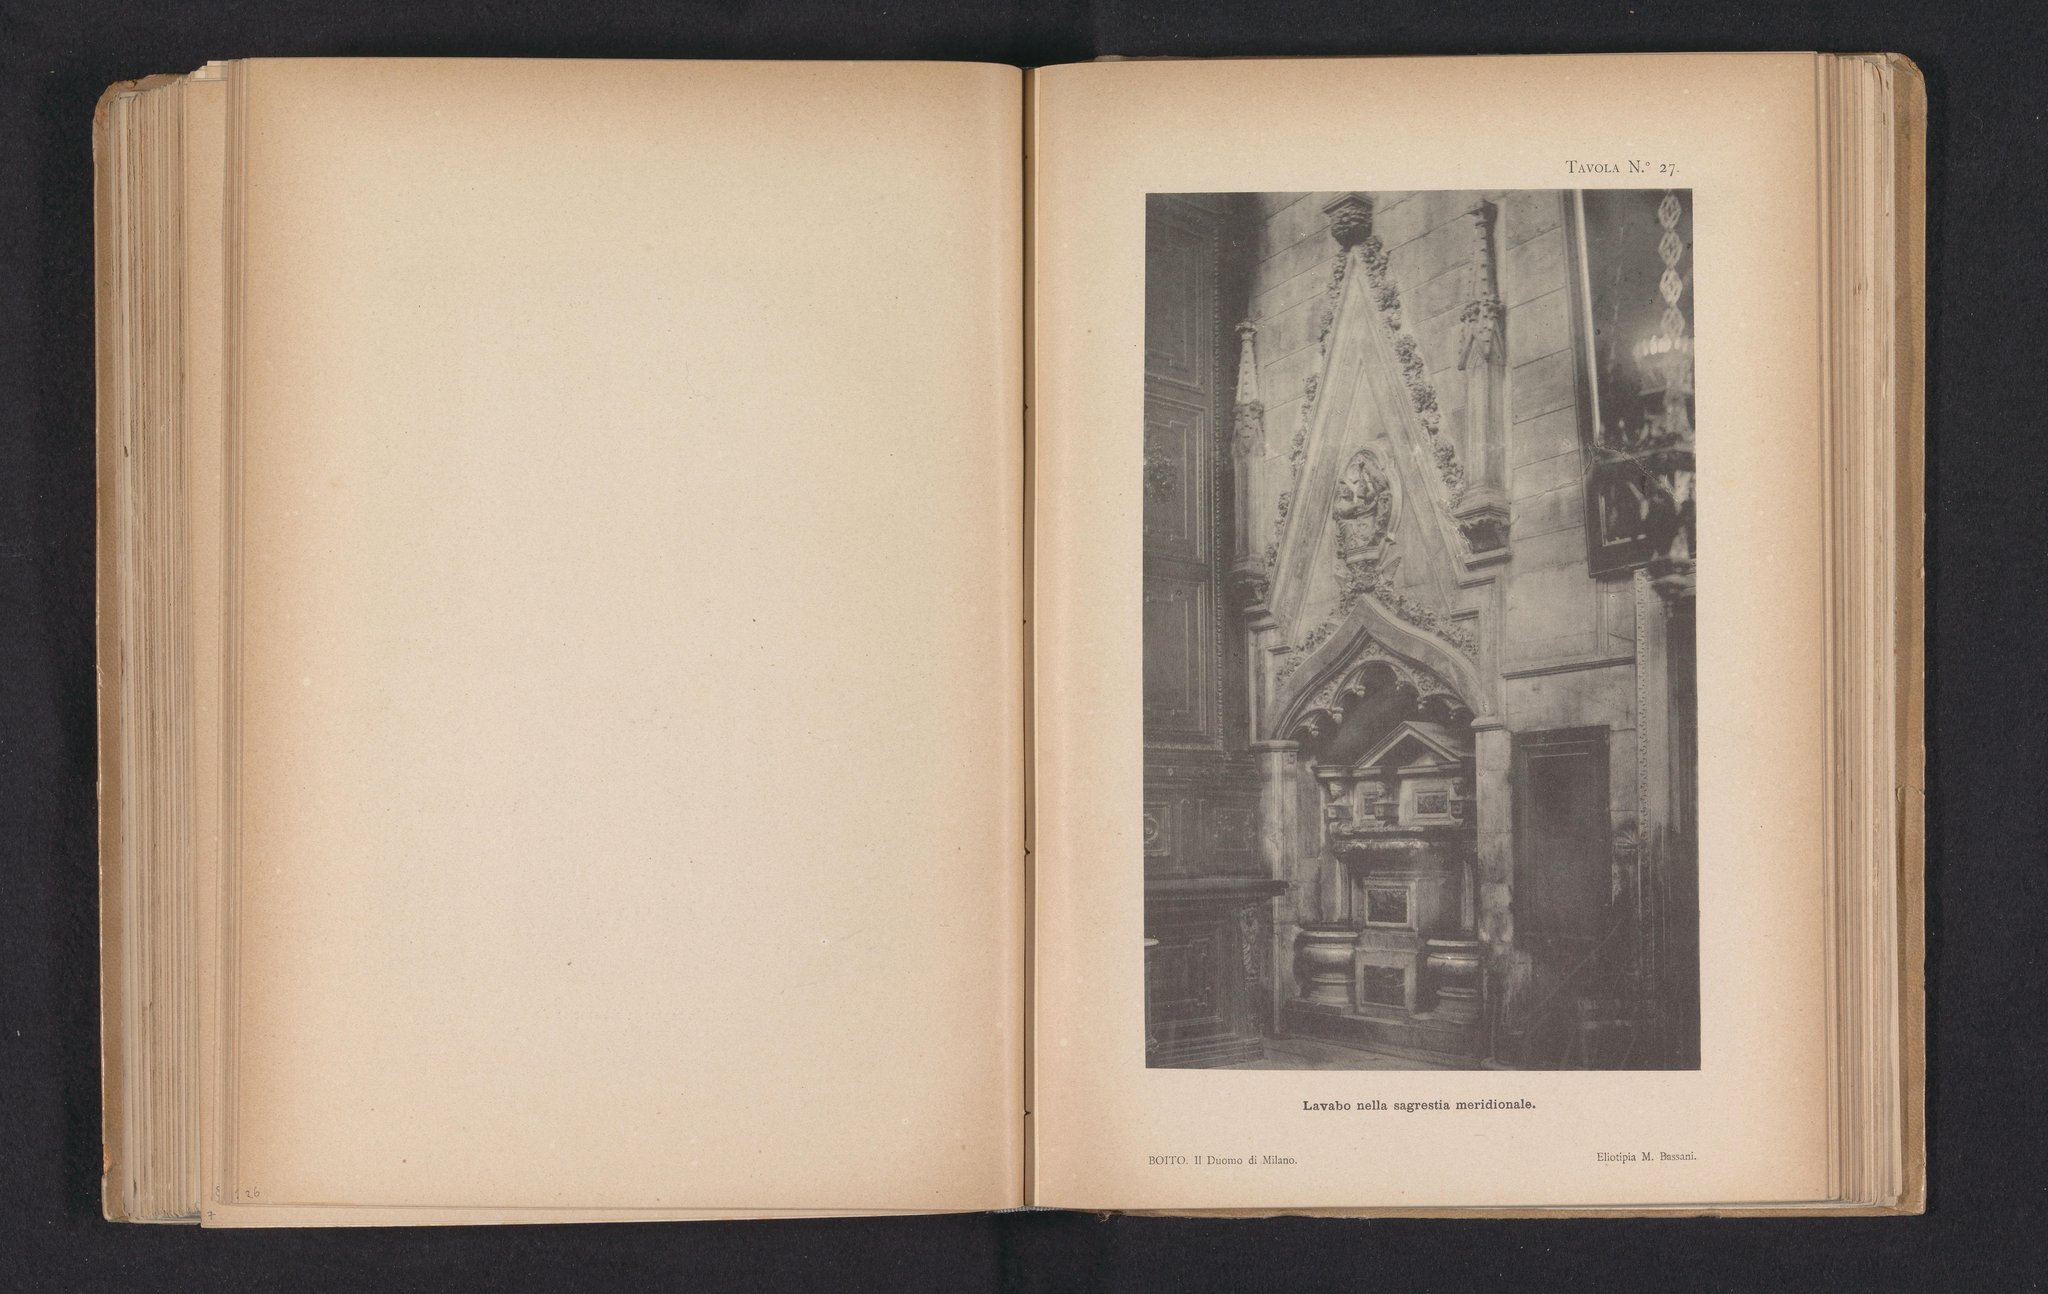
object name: photomechanical print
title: Lavabo nella sagrestia meridionale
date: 1879-1889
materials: paper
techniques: photograph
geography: milan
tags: sink, basin, parts of church interior: sacristy, decorating 'en relief', appliquéing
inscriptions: number: ‘Tavola No. 27.’